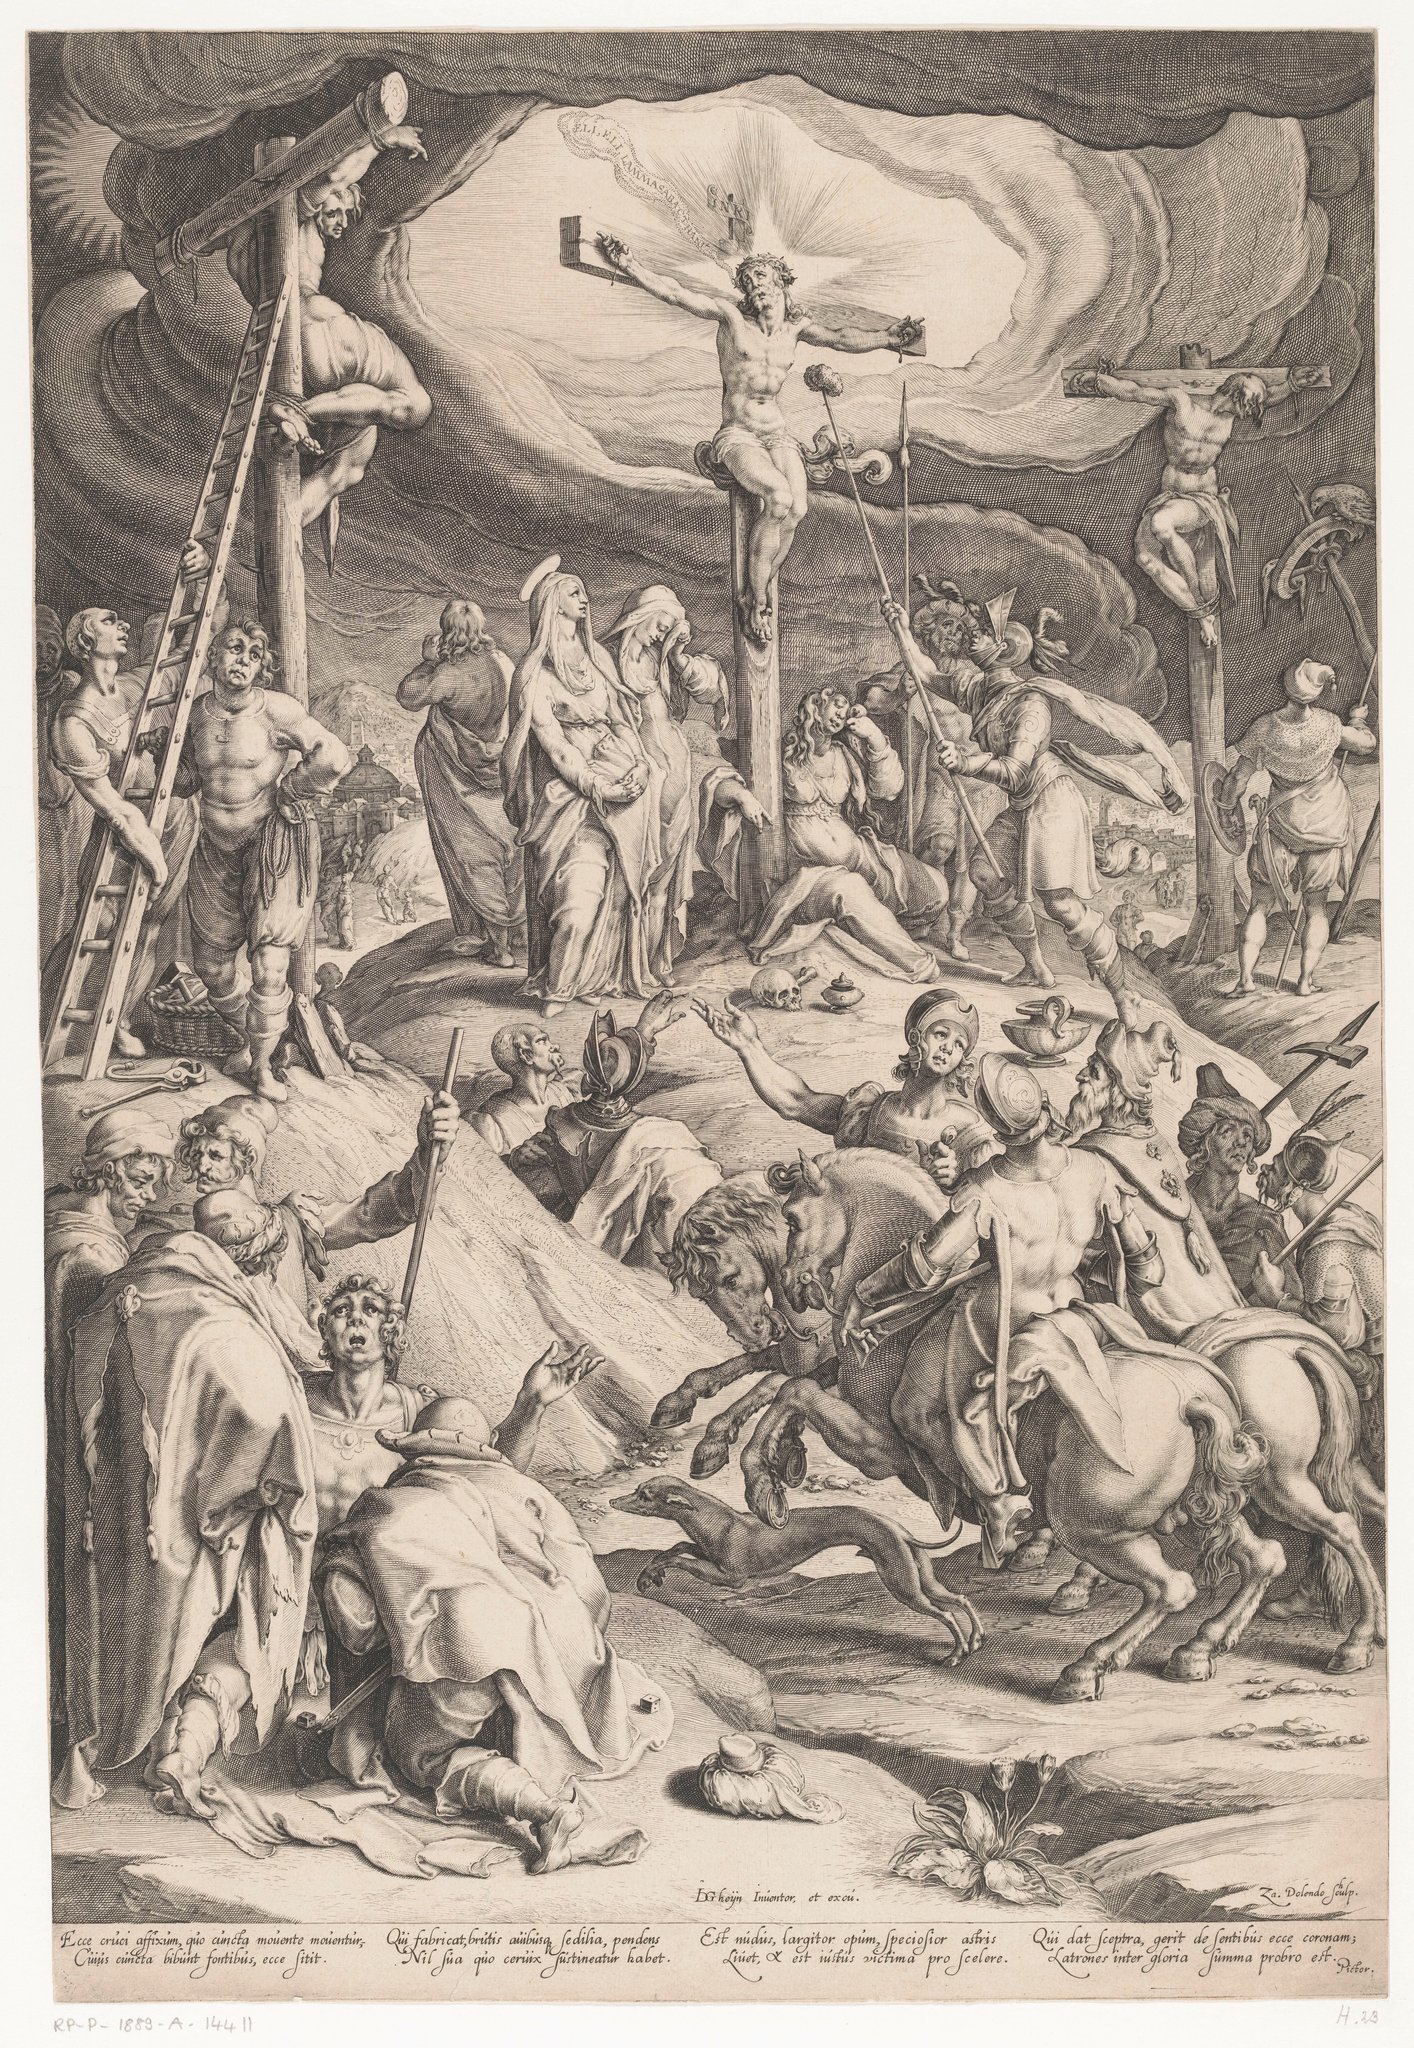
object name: print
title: Kruisiging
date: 1595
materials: paper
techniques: engraving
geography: leiden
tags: the crucifixion of christ: christ's death on the cross; golgotha (matthew 27:45-58; mark 15:33-45; luke 23:44-52; john 19:25-38)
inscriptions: collector's mark: Lugt 2228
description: Christus aan het kruis tussen de twee gekruisigde dieven. Maria Magdalena zit aan de voet van het kruis, Maria staat naast het kruis en Johannes heeft zich afgewend. Een soldaat dept met een spons op een lans Christus gezicht. Links op de voorgrond dobbelen de soldaten om Christus kleren.